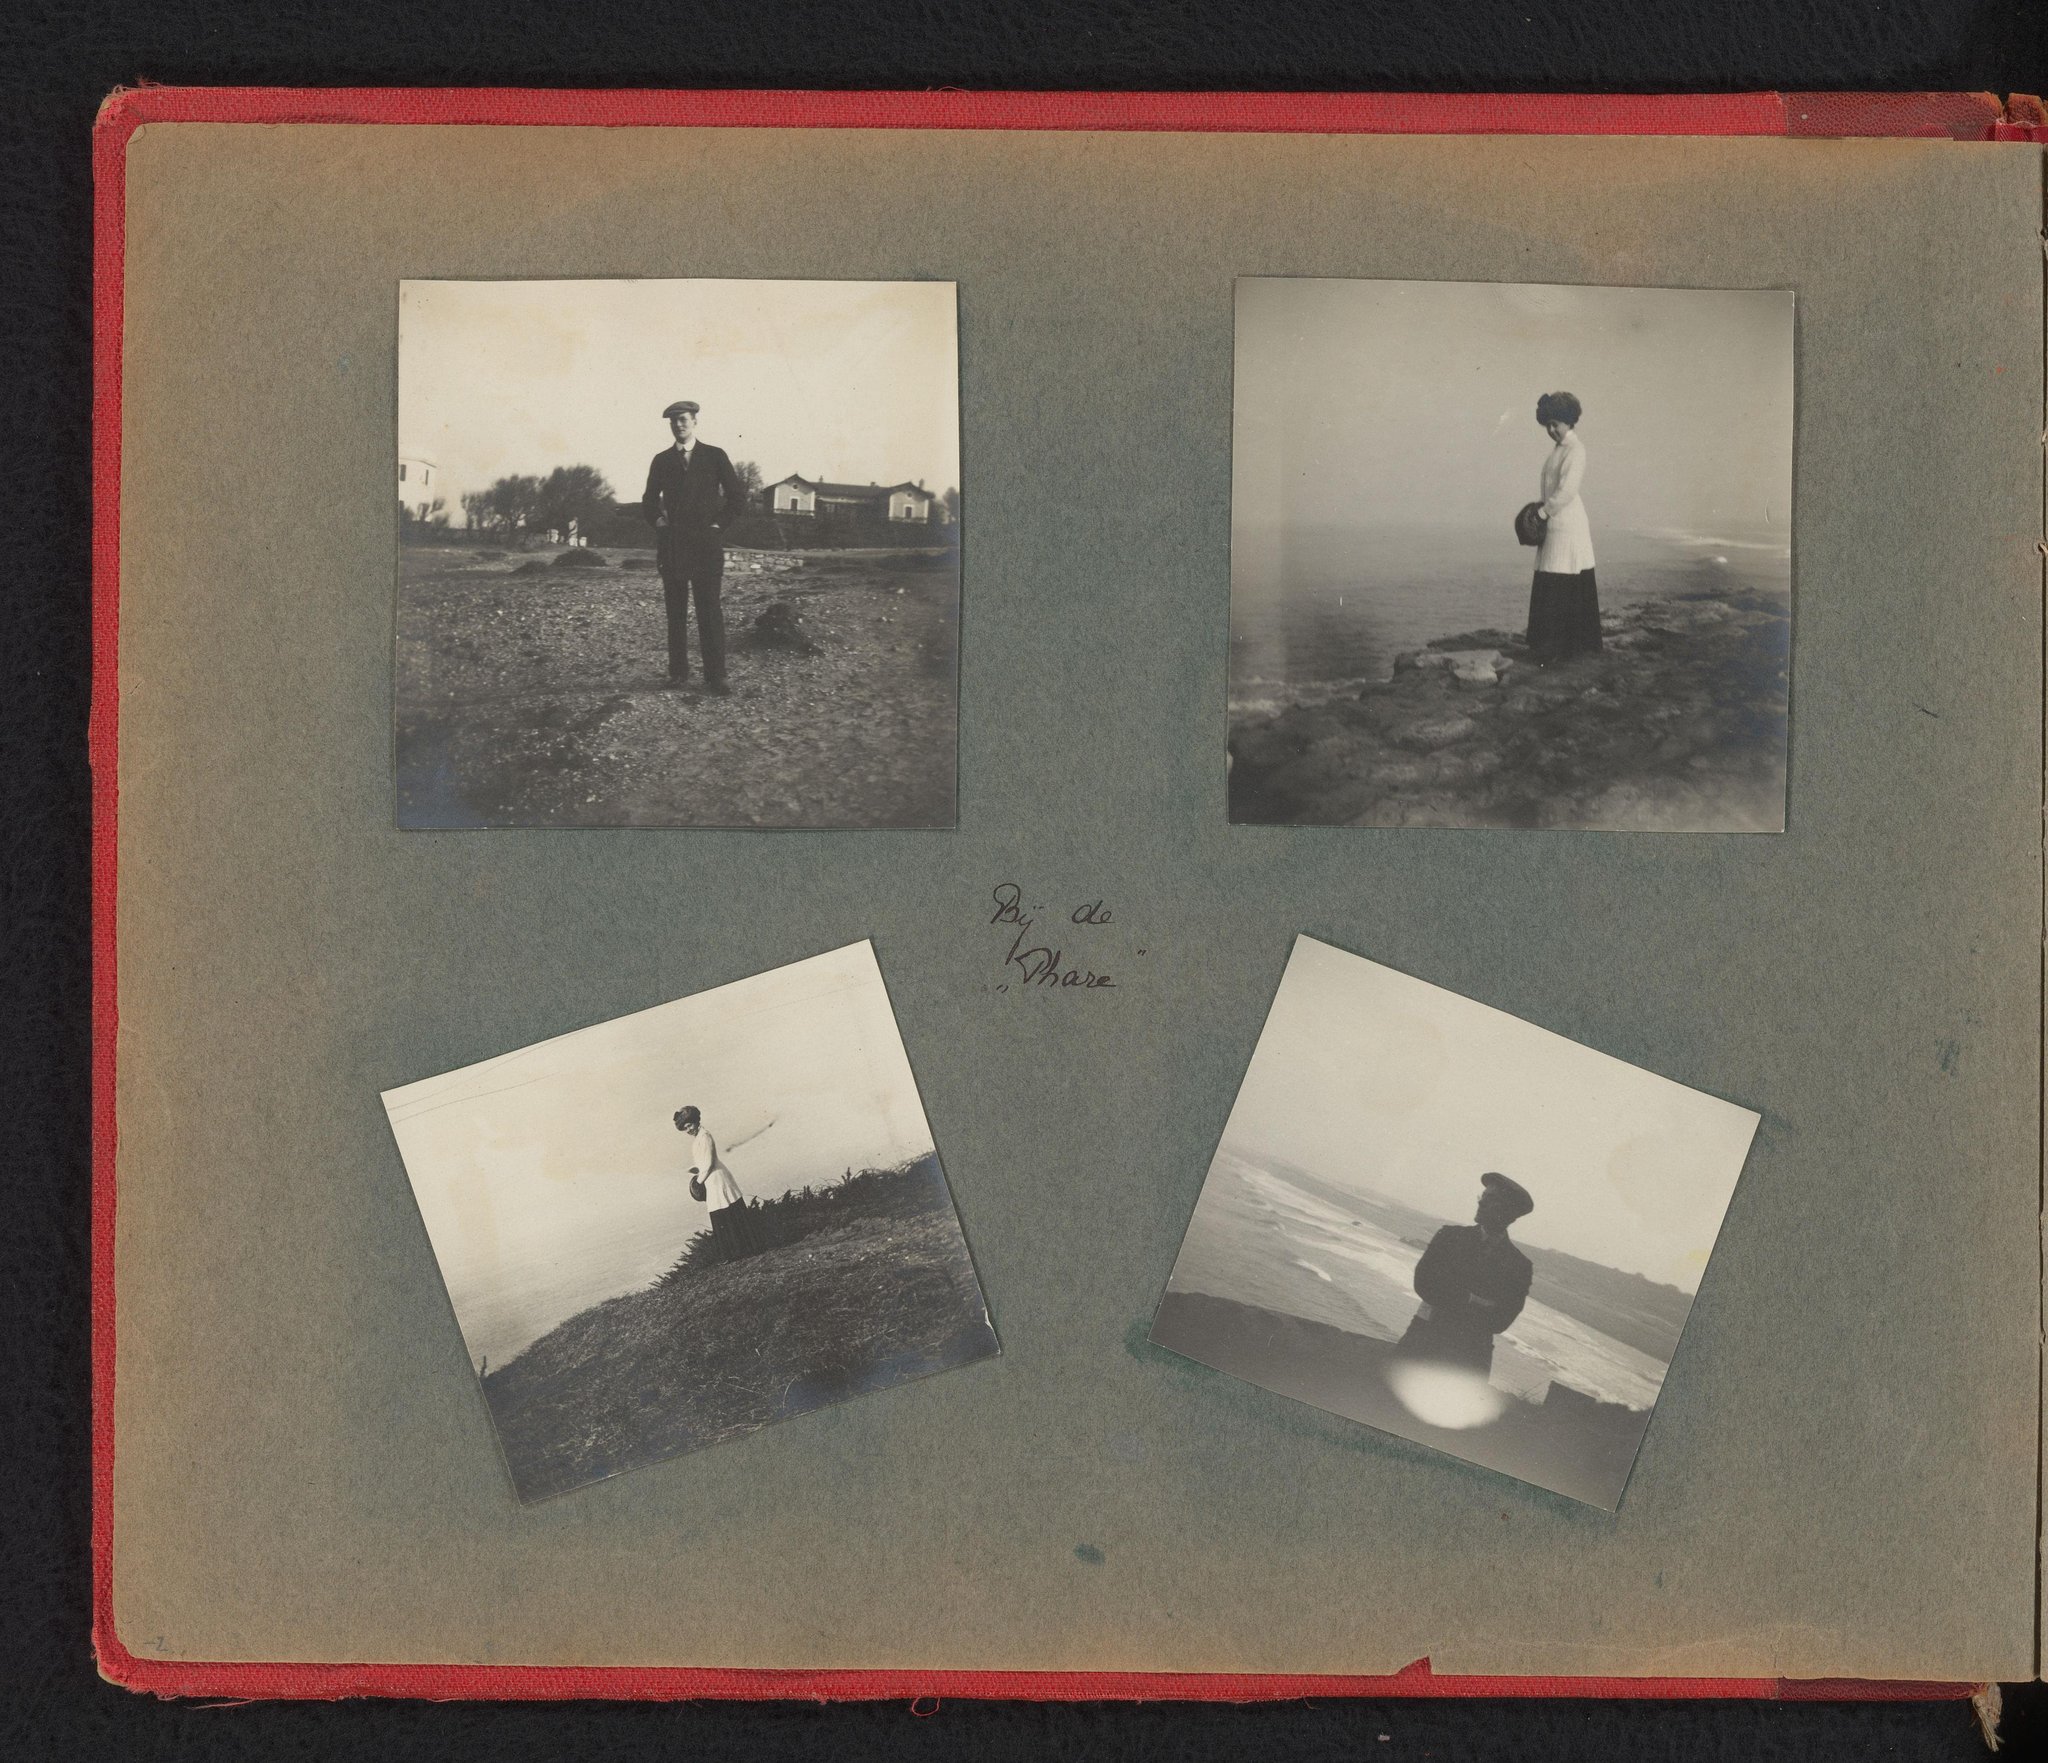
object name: album leaf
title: Bij de Phare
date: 1901-1911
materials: paper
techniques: gelatin silver print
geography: biarritz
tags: charlotte alida boelen-matthes (lot), amsterdam, joan gerard boelen, lighthouse, lightship, ocean, beach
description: Deze foto's zijn onderdeel van een album.